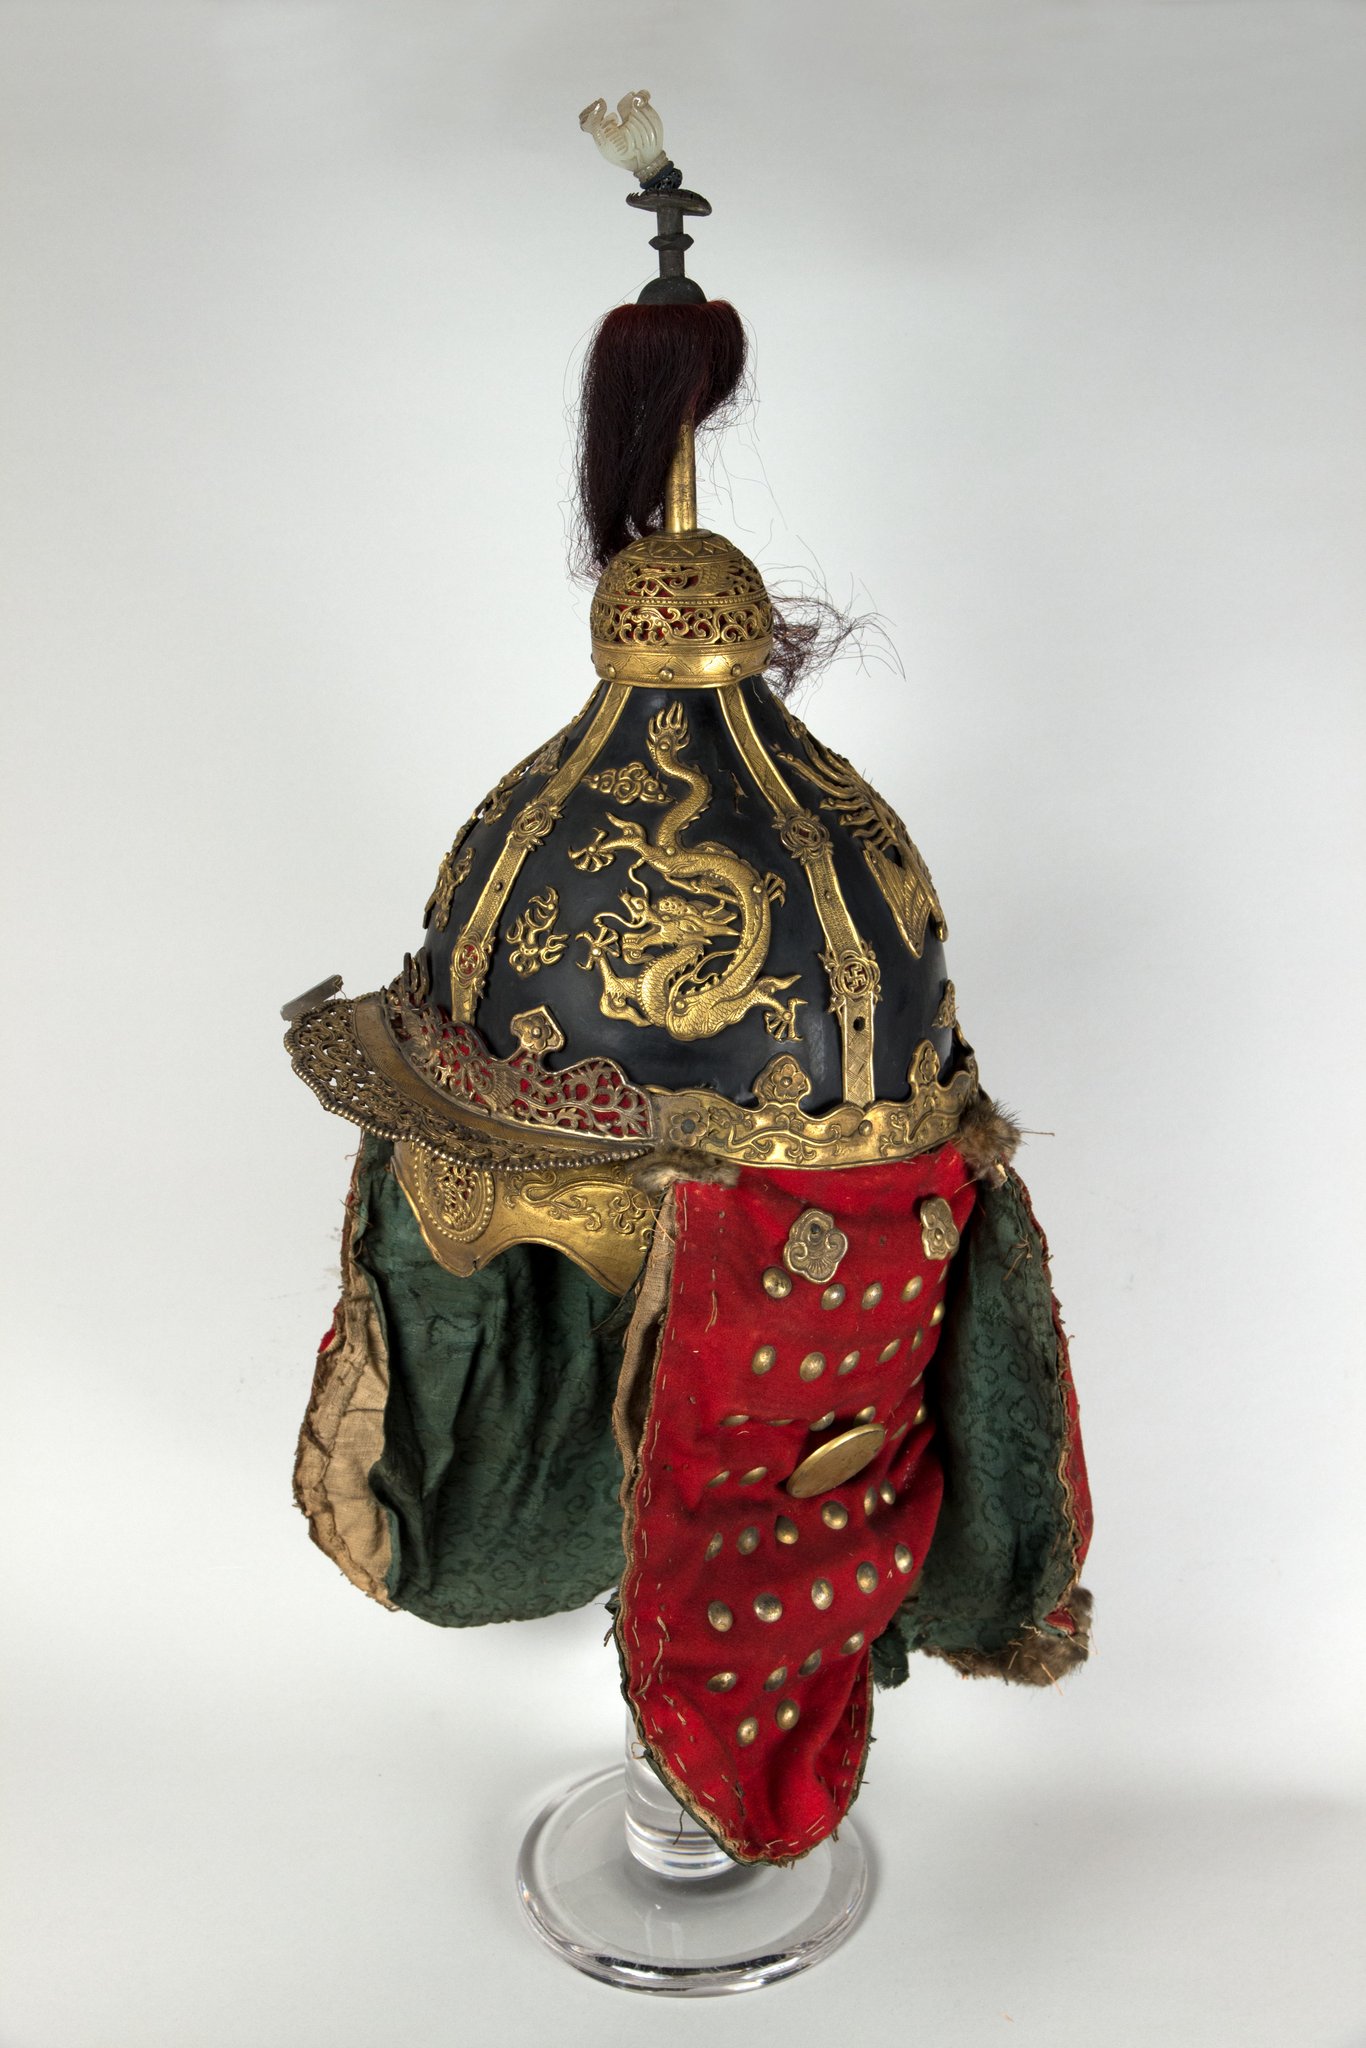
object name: helmet with crest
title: Officer's Helmet with Crest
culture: korean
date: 1501-1900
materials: fur, hair, iron, jade, leather, textile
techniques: gilding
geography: korea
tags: dragons